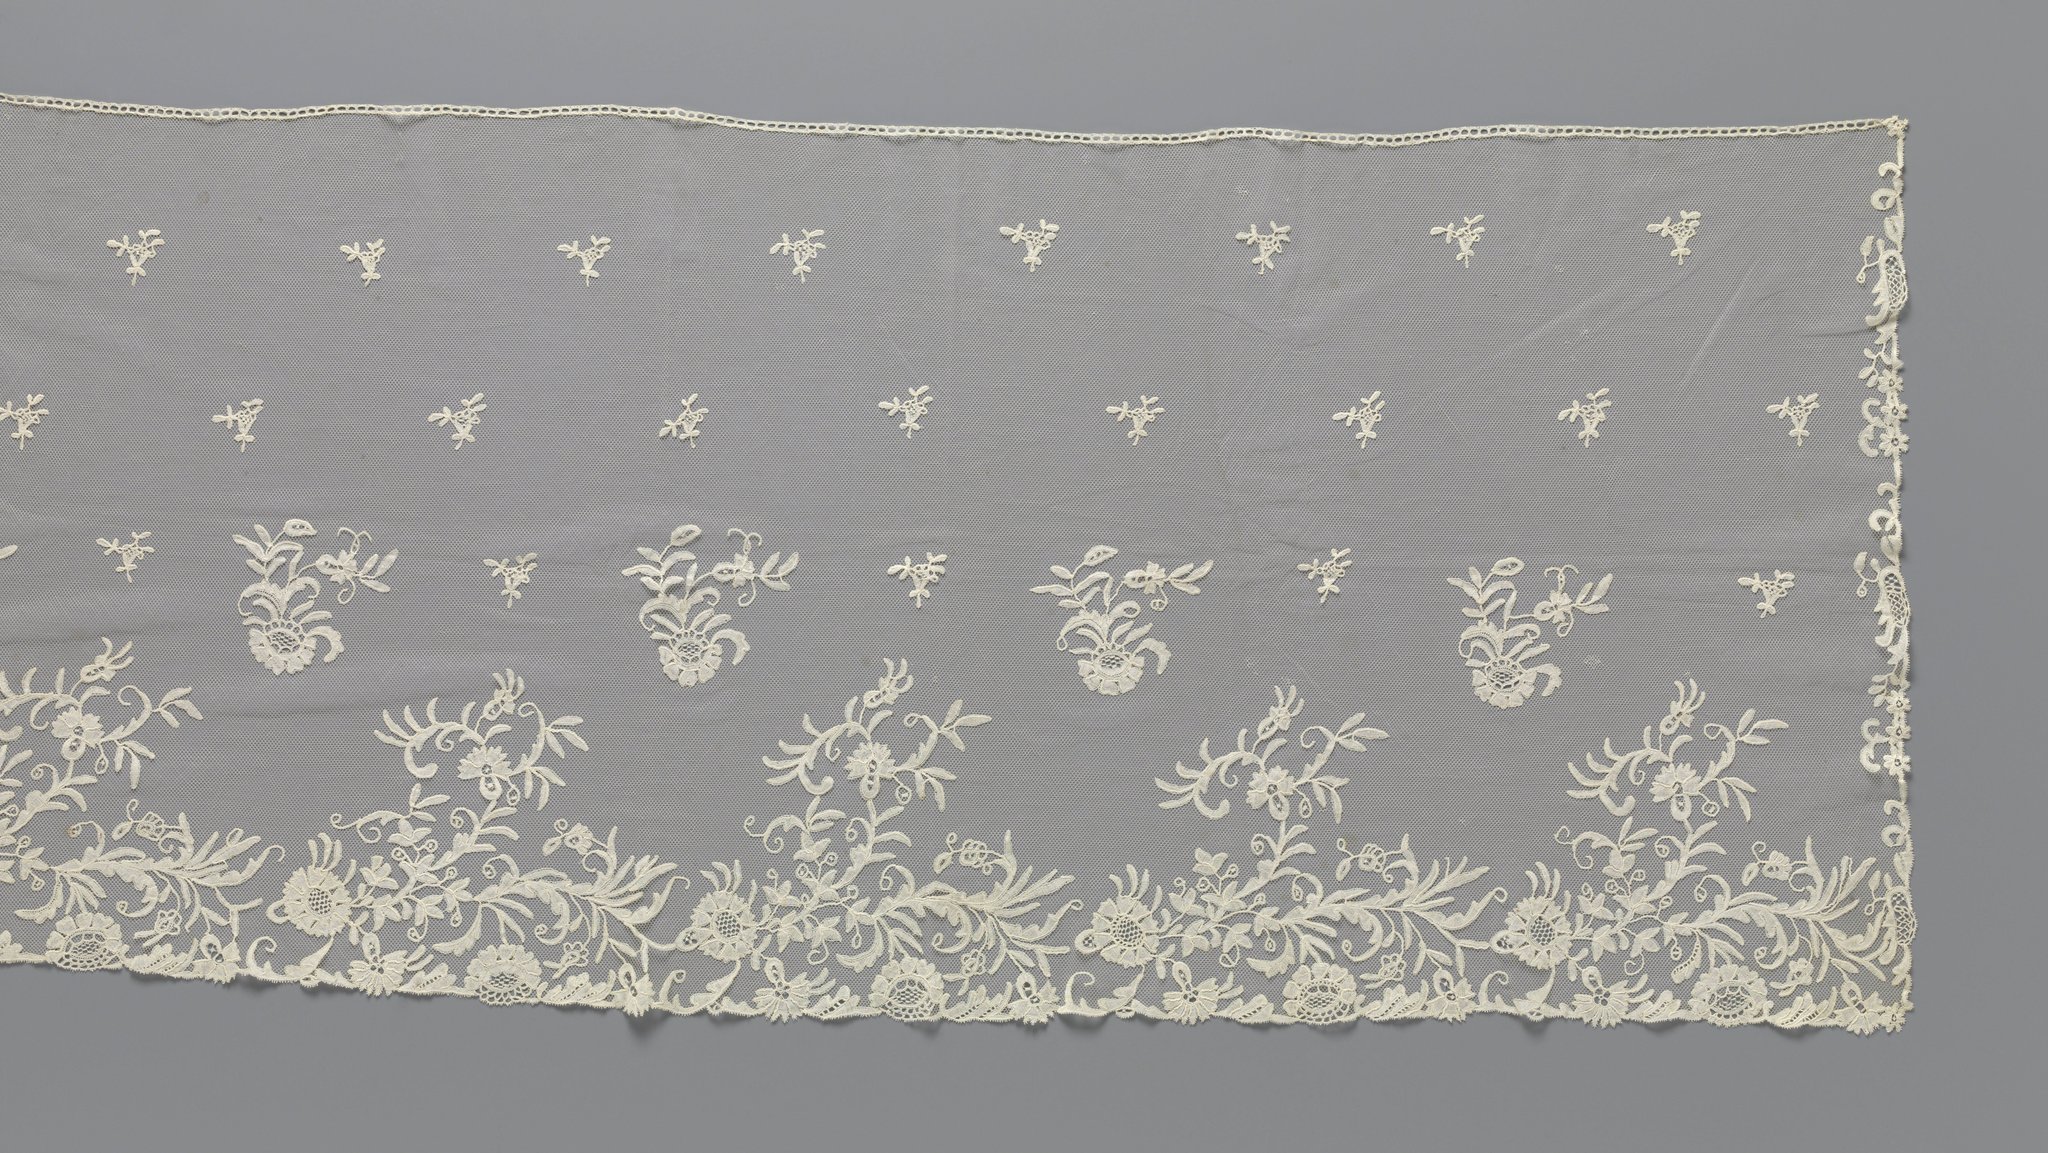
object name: hat veil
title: Hoedensluier van applicatiekant met korenbloemen en margrieten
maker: Anonymous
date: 1825-1849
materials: linen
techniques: lace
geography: brussels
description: Hoedensluier van applicatiekant: kloskant geappliceerd op machinale tule. Rechthoekig model. Het zich herhalende patroon bestaat uit drie rijen met wijd verspreid steeds één kelkbloempje tussen enkele bladertakjes. Tussen de opeenvolgende kelkbloempjes in de onderste rij hangt een bloemtak met één margriet en twee kleinere bloemen en bladeren. Langs de onderzijde van de sluier is het patroon dichter en bestaat uit een liggende bloemtak met twee margrieten, drie korenbloemen of anjers en enkele andere en kleinere bloemen. De meeste bladeren zijn langgerekt en min of meer ovaal van vorm waarbij enkele bladeren ingesneden zijn en omkrullen. De bloemen en enkele bladeren, die aan de tak naar beneden hangen vormen schulpen langs de onderzijde van de sluier, die aaneengeschakeld met andere blaadjes die langs de onderzijde zijn geappliceerd de schulpenrand vormen. Een aangepaste schulpenrand loopt door langs de korte zijden van de sluier. De motieven zijn geklost in linnenslag met opengewerkte randjes en ze zijn gedeeltelijk voorzien van contourdraden. Op verschillende plaatsen langs (bloem)bladeren zijn gekloste reliëfcontouren toegepast. Vormslagen zijn toegepast in bloemen (één of enkele per motief) en in siergronden in voornamelijk de margrieten. De motieven zijn met elkaar verbonden door een machinale tulegrond. De schulpenrand langs de onderzijde en de korte zijden zijn afgewerkt met picots. De bovenzijde is afgewerkte met een geklost randje van opengewerkte ovaaltjes.